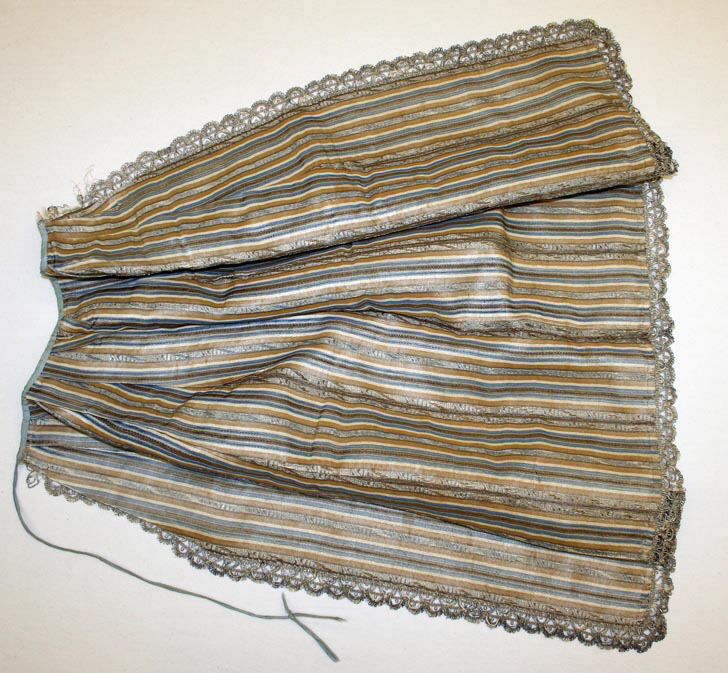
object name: apron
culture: british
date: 1701-1725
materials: metal, silk